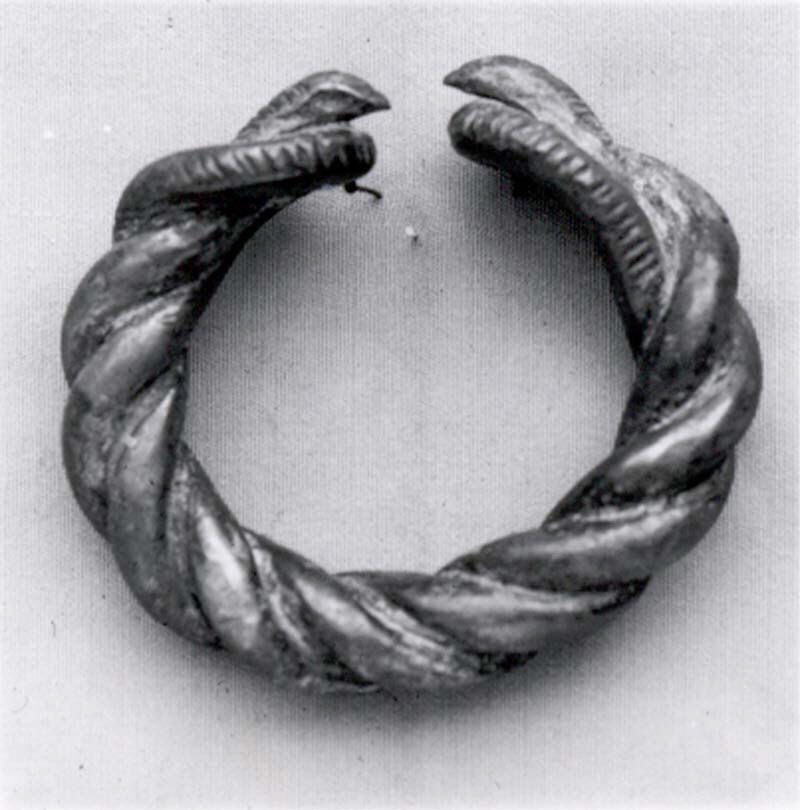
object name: bracelet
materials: bronze